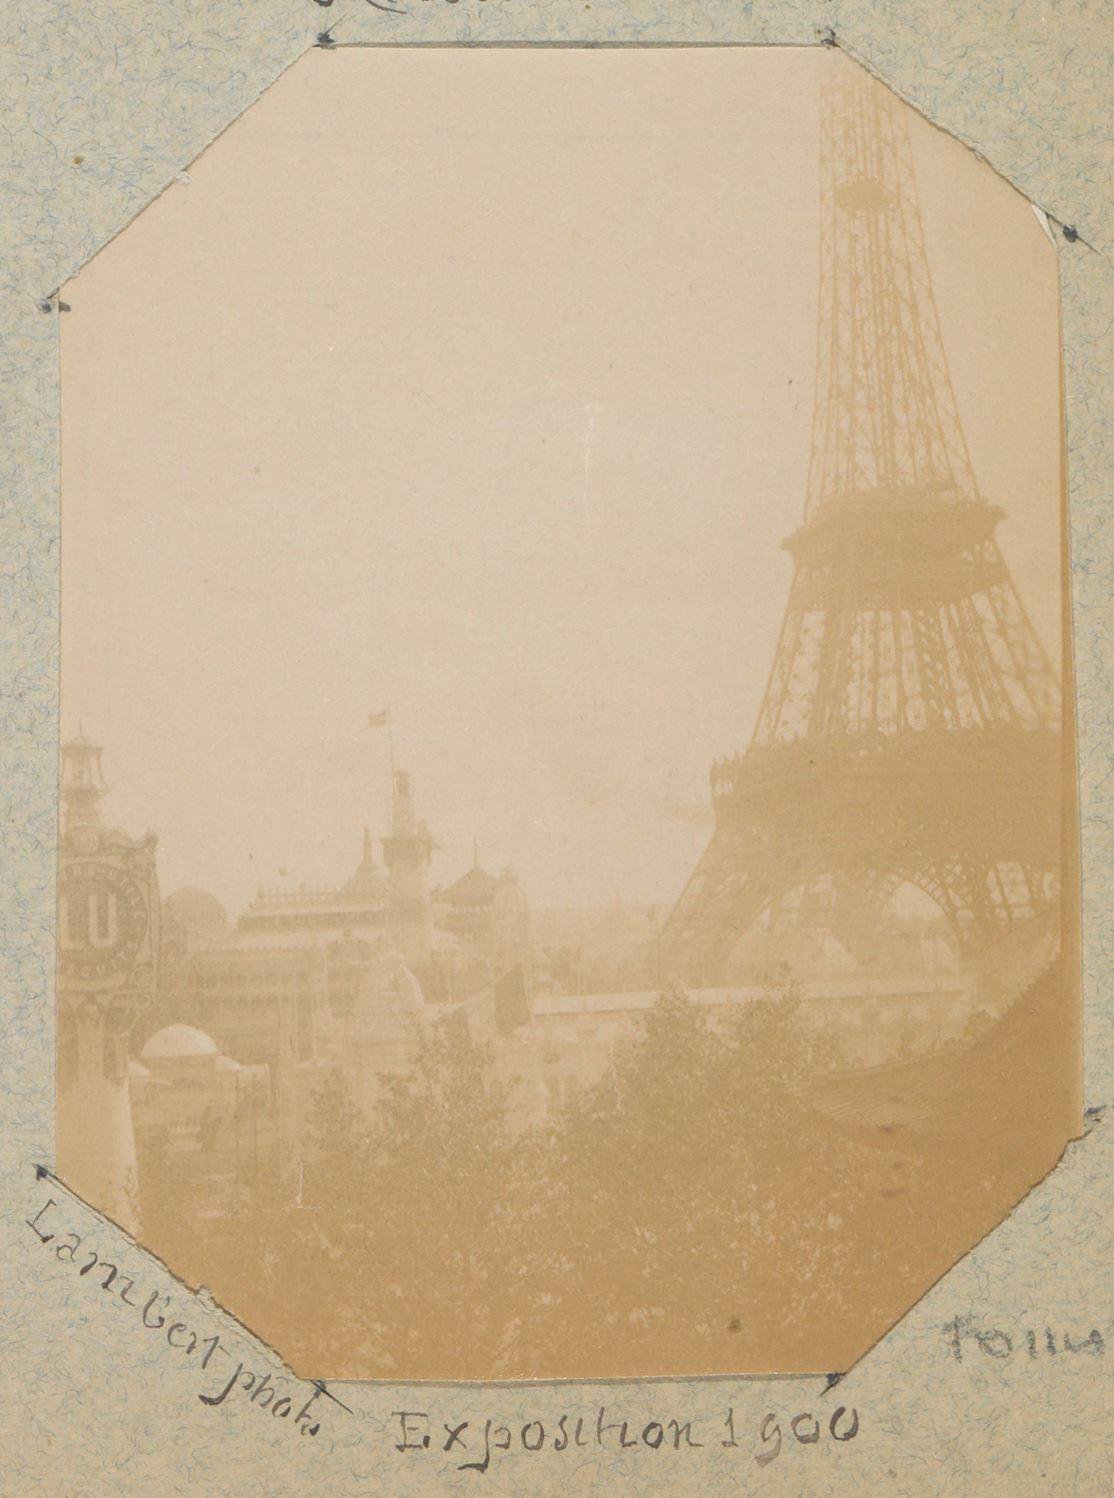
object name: album leaf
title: Gezicht op het terrein van de Wereldtentoonstelling van 1900 in Parijs met rechts de Eiffeltoren en links een reclame voor LU biscuits (Lefèvre Utile)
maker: m. lambert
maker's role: fotograaf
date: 1900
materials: paper, photographic support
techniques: albumen print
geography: paris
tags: advertising, world fair, world exhibition, paris, eiffel tower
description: Onderdeel van Album van een Franse amateur met foto's van Frankrijk, Algerije, Palmyra, de Wereldtentoonstelling van 1900 en van bekende Fransen.